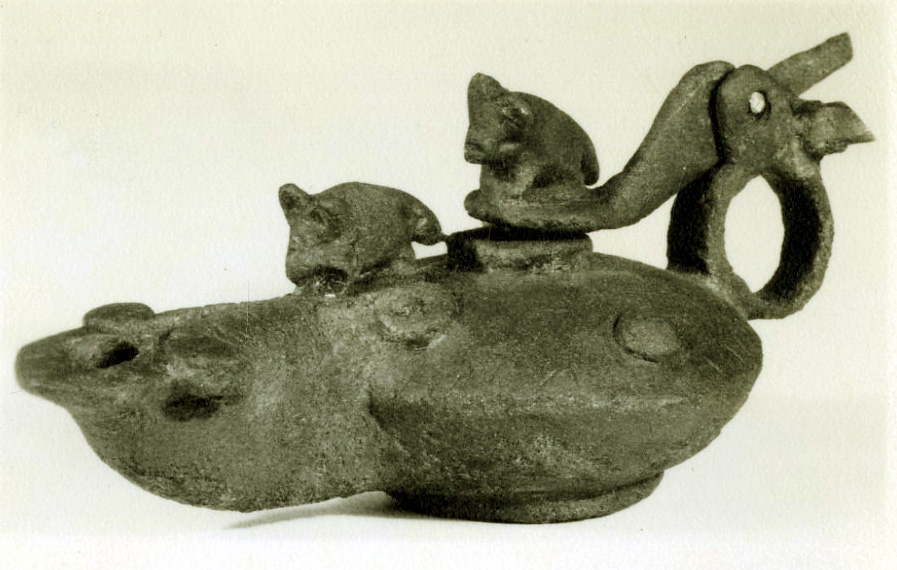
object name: lamp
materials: copper alloy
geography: egypt